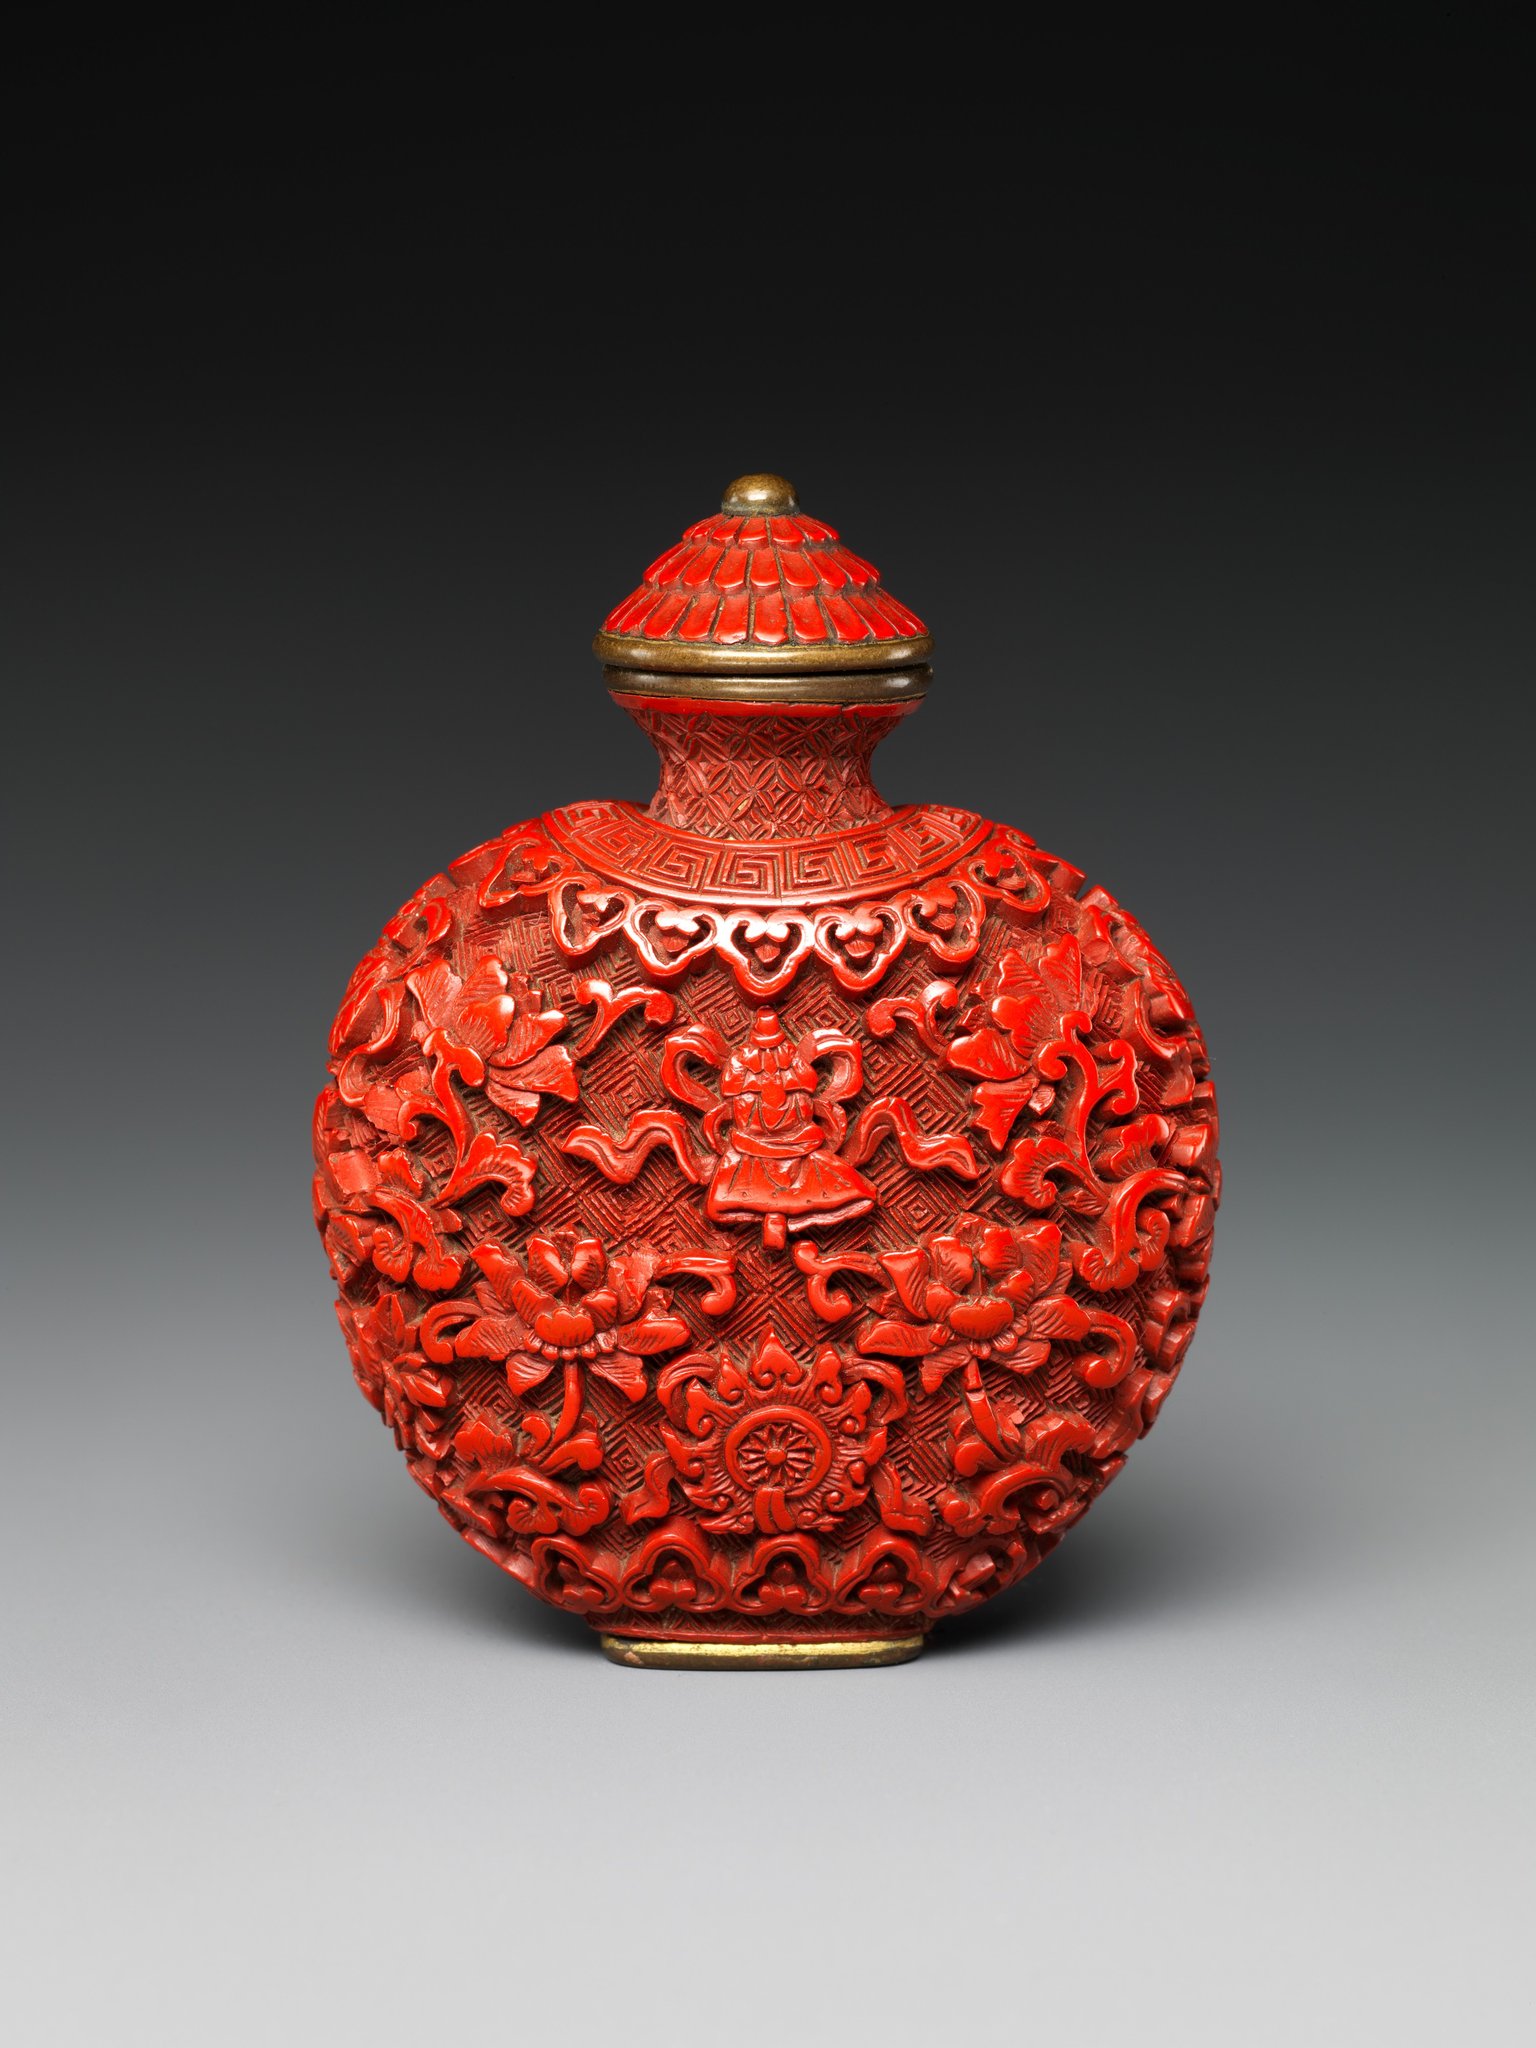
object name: snuff bottle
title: Snuff bottle with Buddhist emblems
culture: chinese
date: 1736-1795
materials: lacquer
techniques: carving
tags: flowers,buddhism,emblems